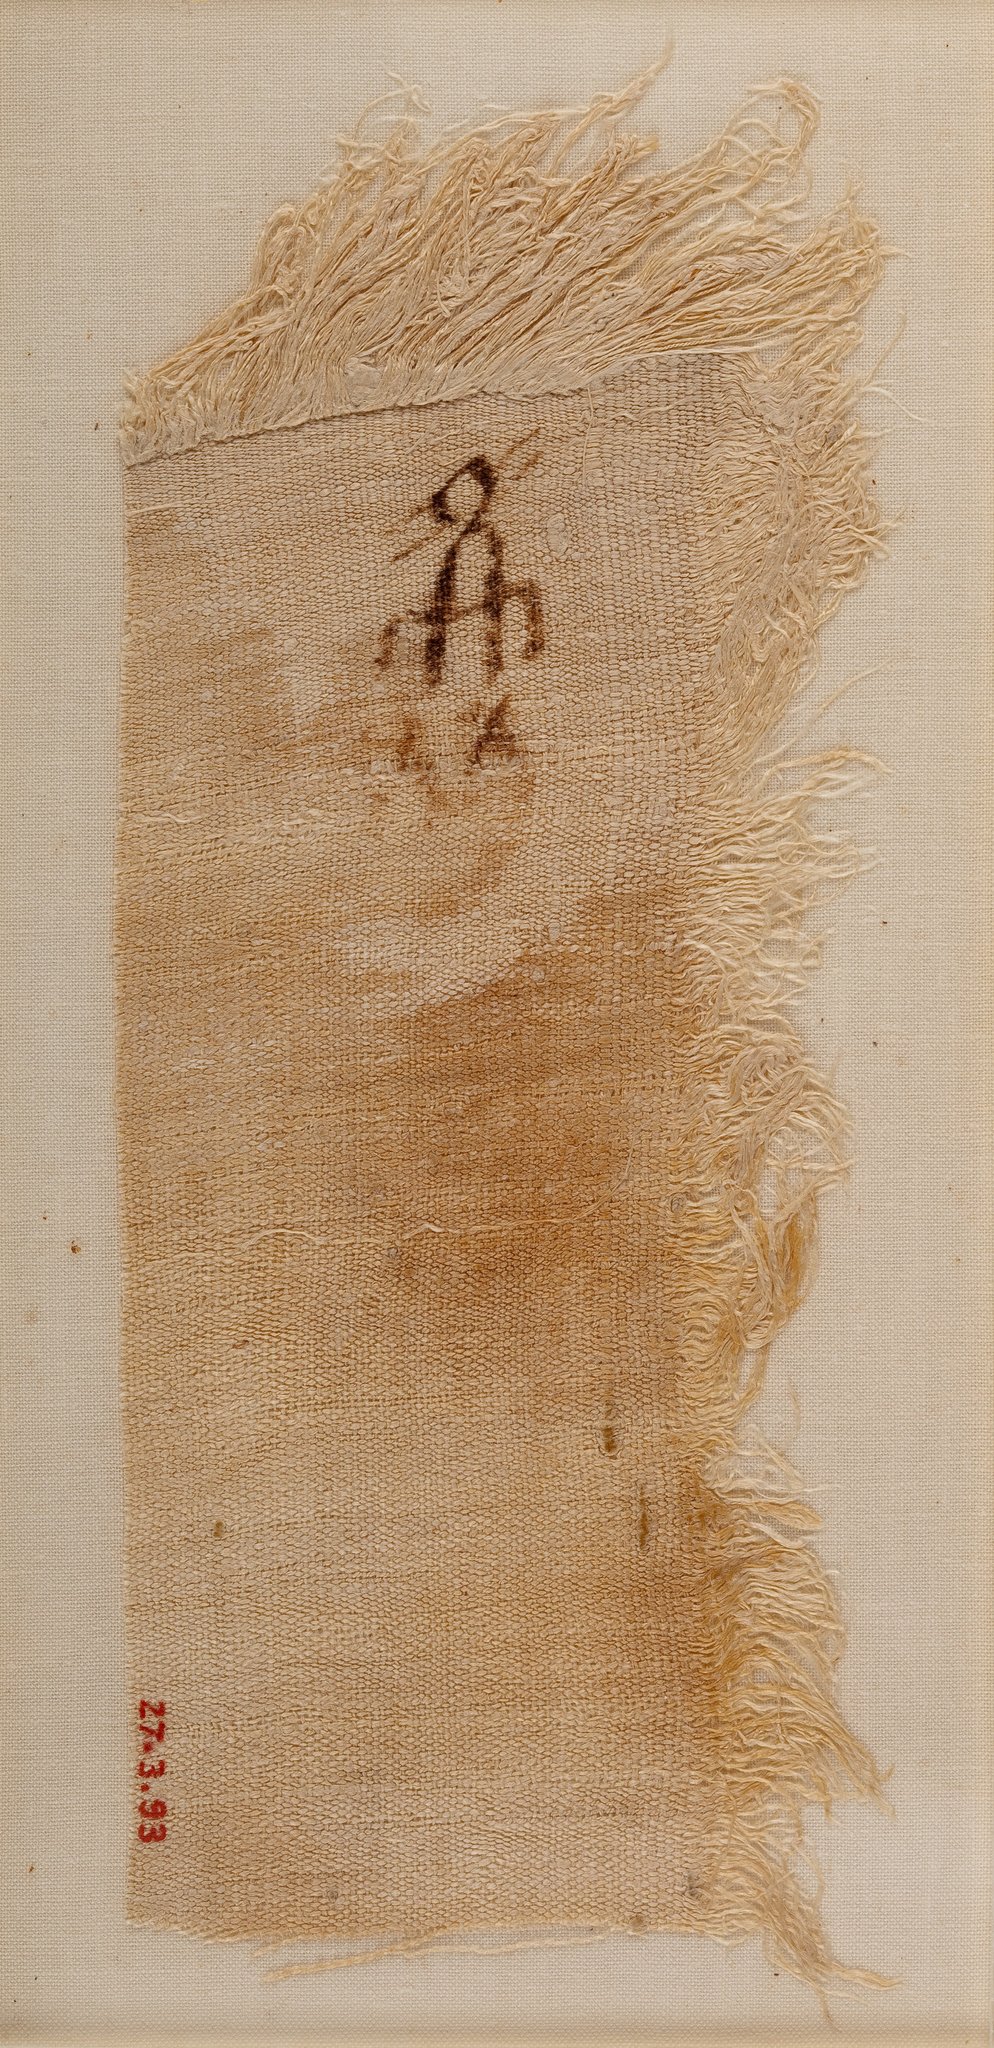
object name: linen mark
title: Linen mark (Type III)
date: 1961-1917 BCE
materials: linen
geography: egypt